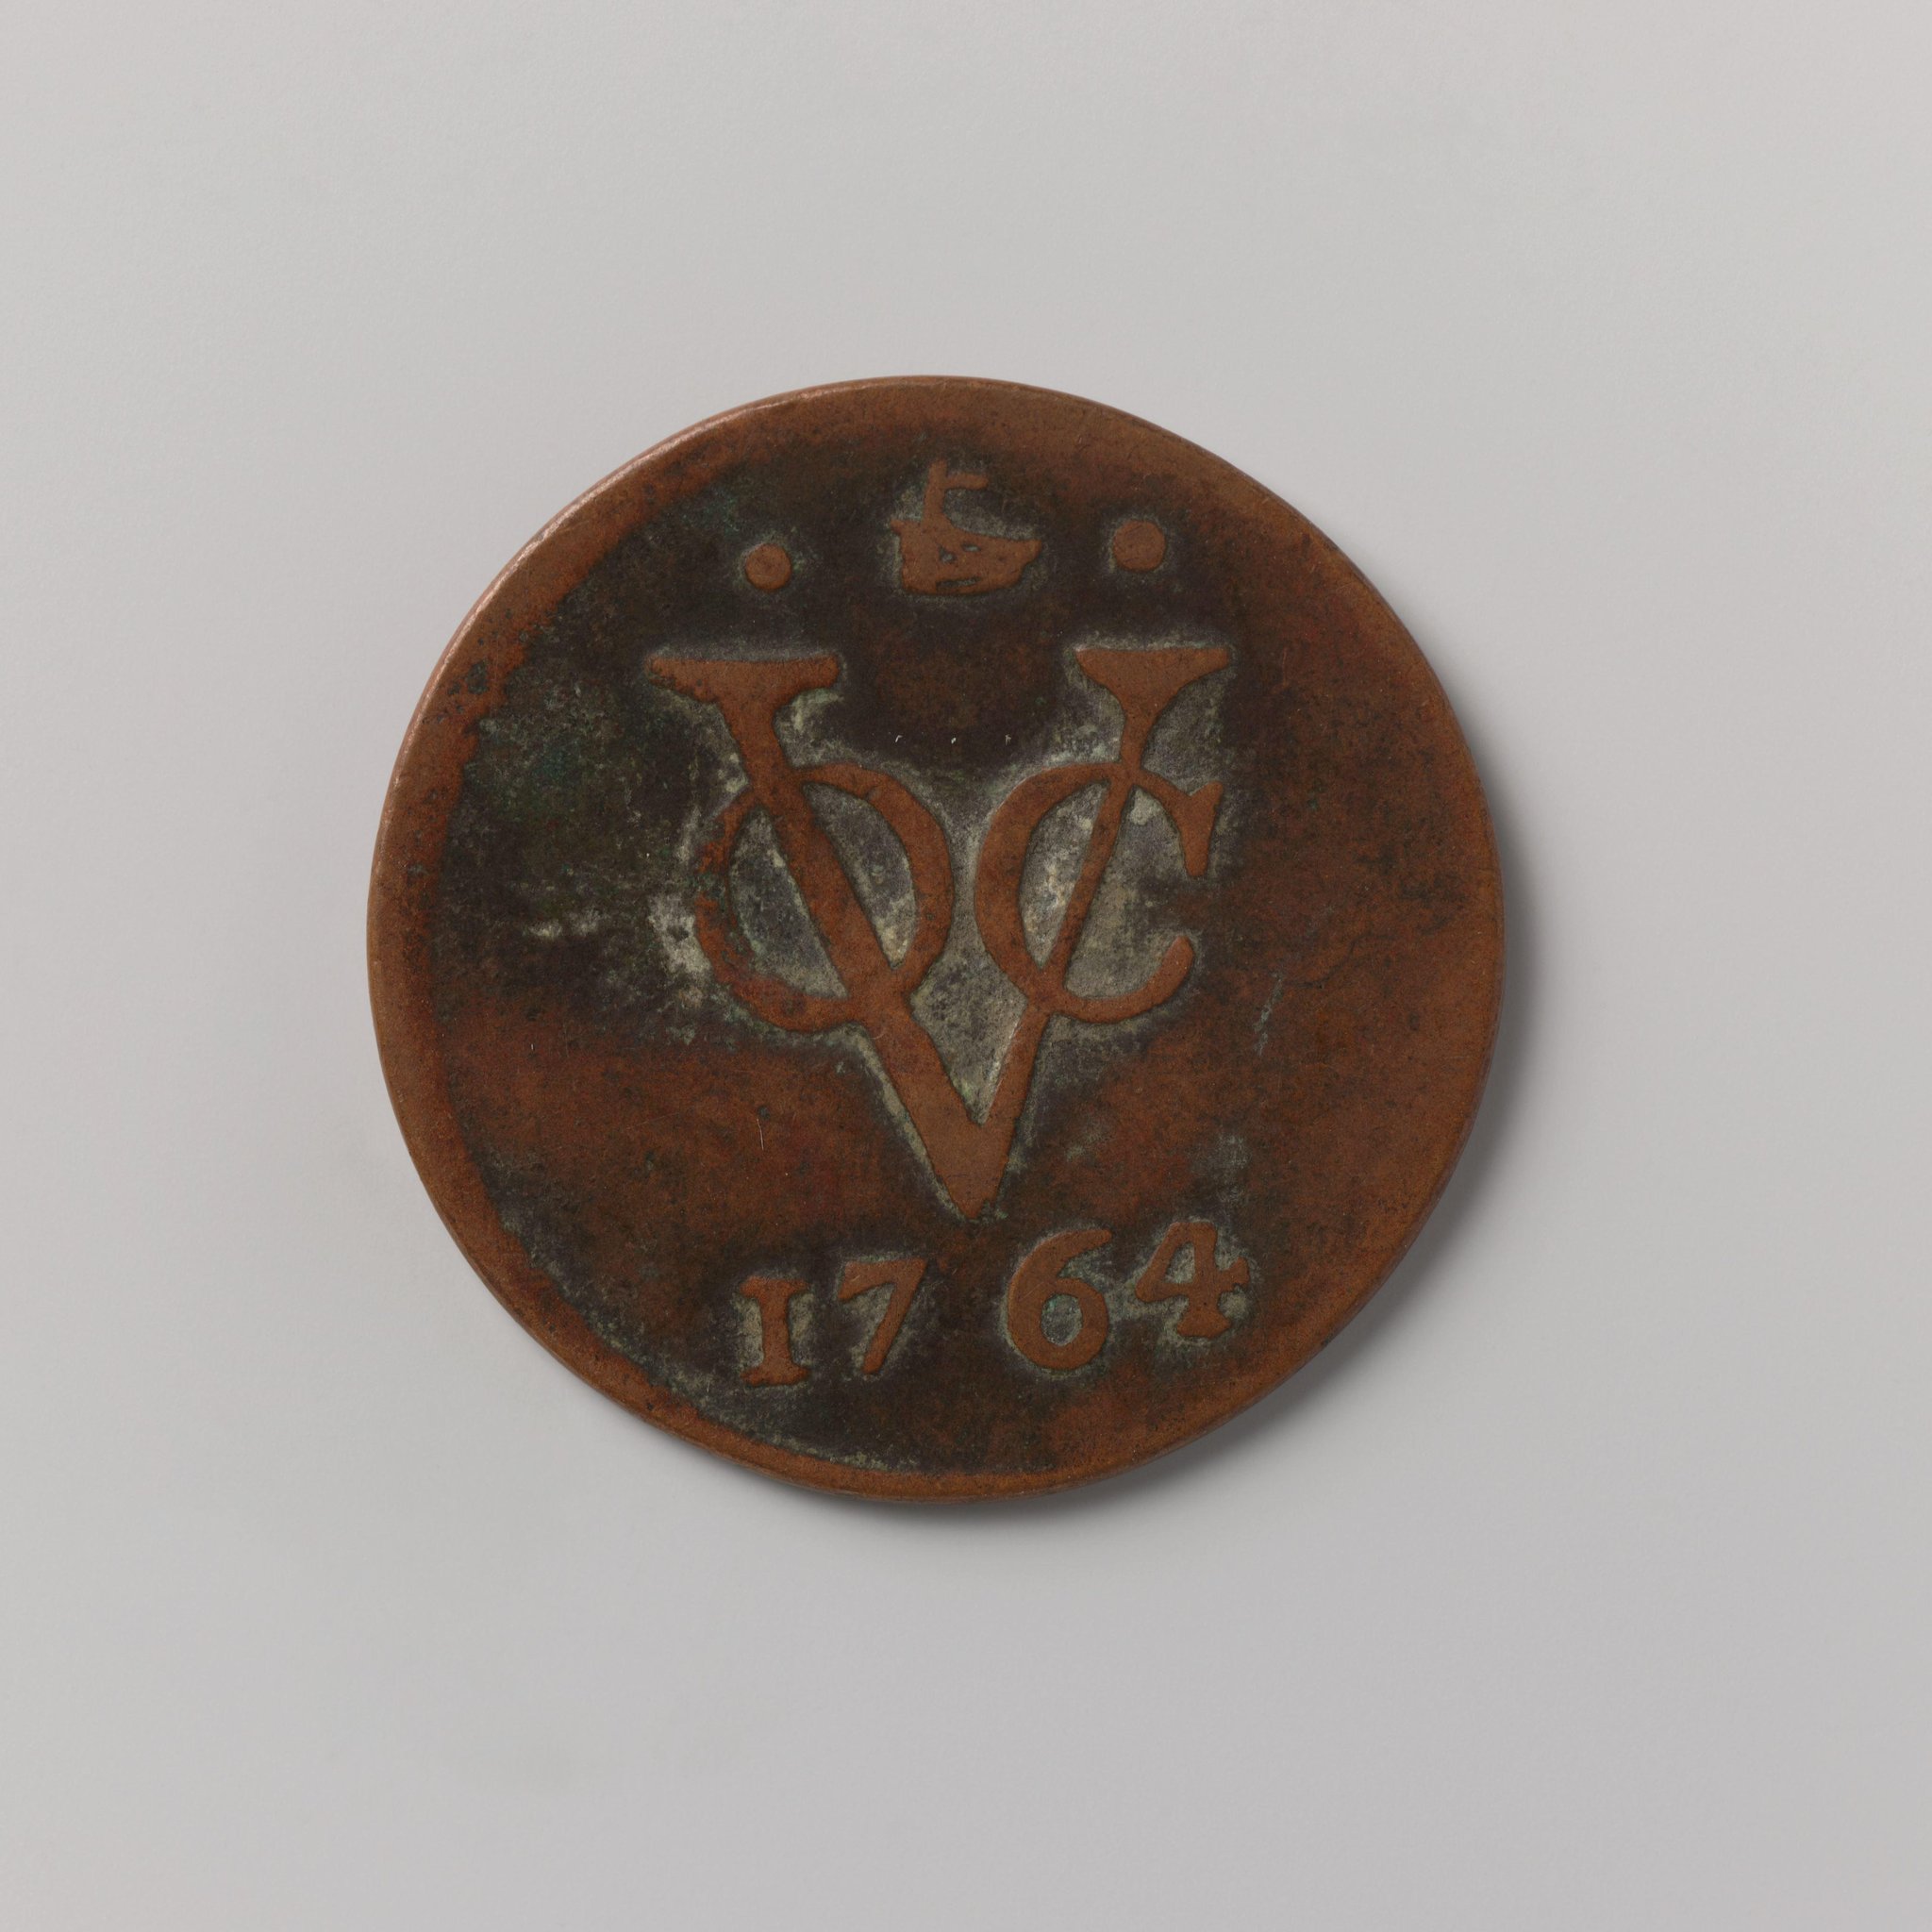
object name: coin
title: Duit van de VOC uit Westfriesland,1764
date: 1764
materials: copper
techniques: striking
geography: enkhuizen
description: Koperen munt. Voorzijde: gekroond wapenschild van Westfriesland. Keerzijde: monogram van de VOC, waarboven muntmeesterteken en waaronder jaartal. Gladde rand.